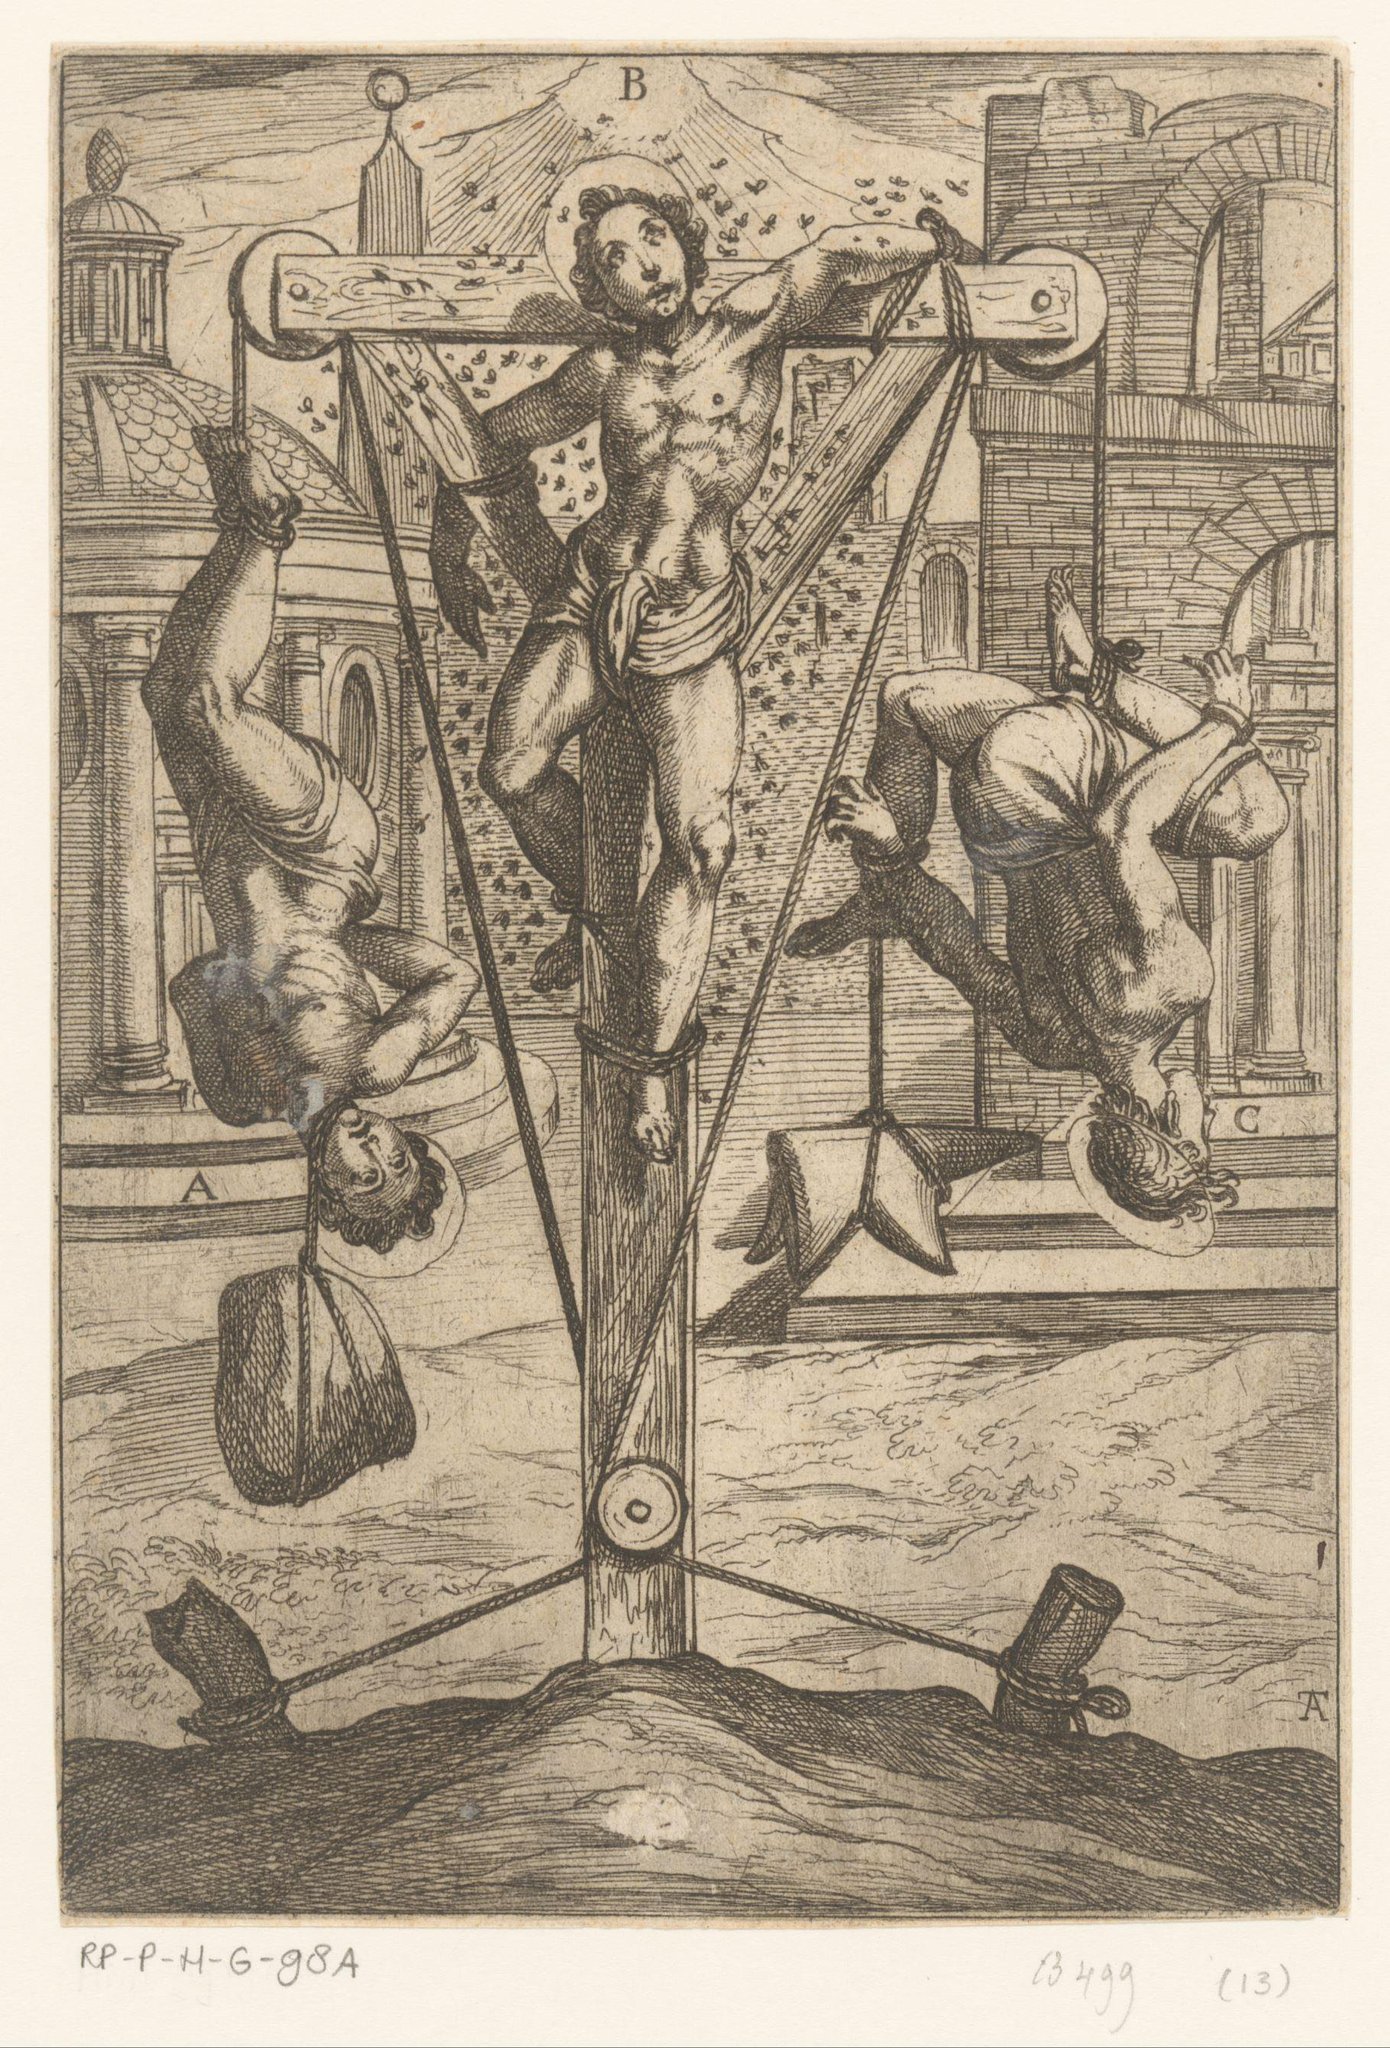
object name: print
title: Varia tormentorum et supplicioru crudelium (...)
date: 1565-1630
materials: paper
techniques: etching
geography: rome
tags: violent death ~ maltreatment, torture, torture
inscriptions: collector's mark: ‘Hinloopen’, collector's mark: Lugt 11, number: ‘1’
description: Deze prent maakt deel uit van een reeks van 47 prenten (+ titelprent) met voorstellingen van martelmethoden. Deze prenten zijn in een andere editie gebruikt als illustraties voor Antonio Gallonio's 'Trattato degli Instrumenti di Martirio e delle Varie Maniere di Martoriare Usate dai Gentili contro Christiani' (Rome, Ascanio en Girolamo Dongangeli, 1591). Midden onder nummer 13 weggekrast.